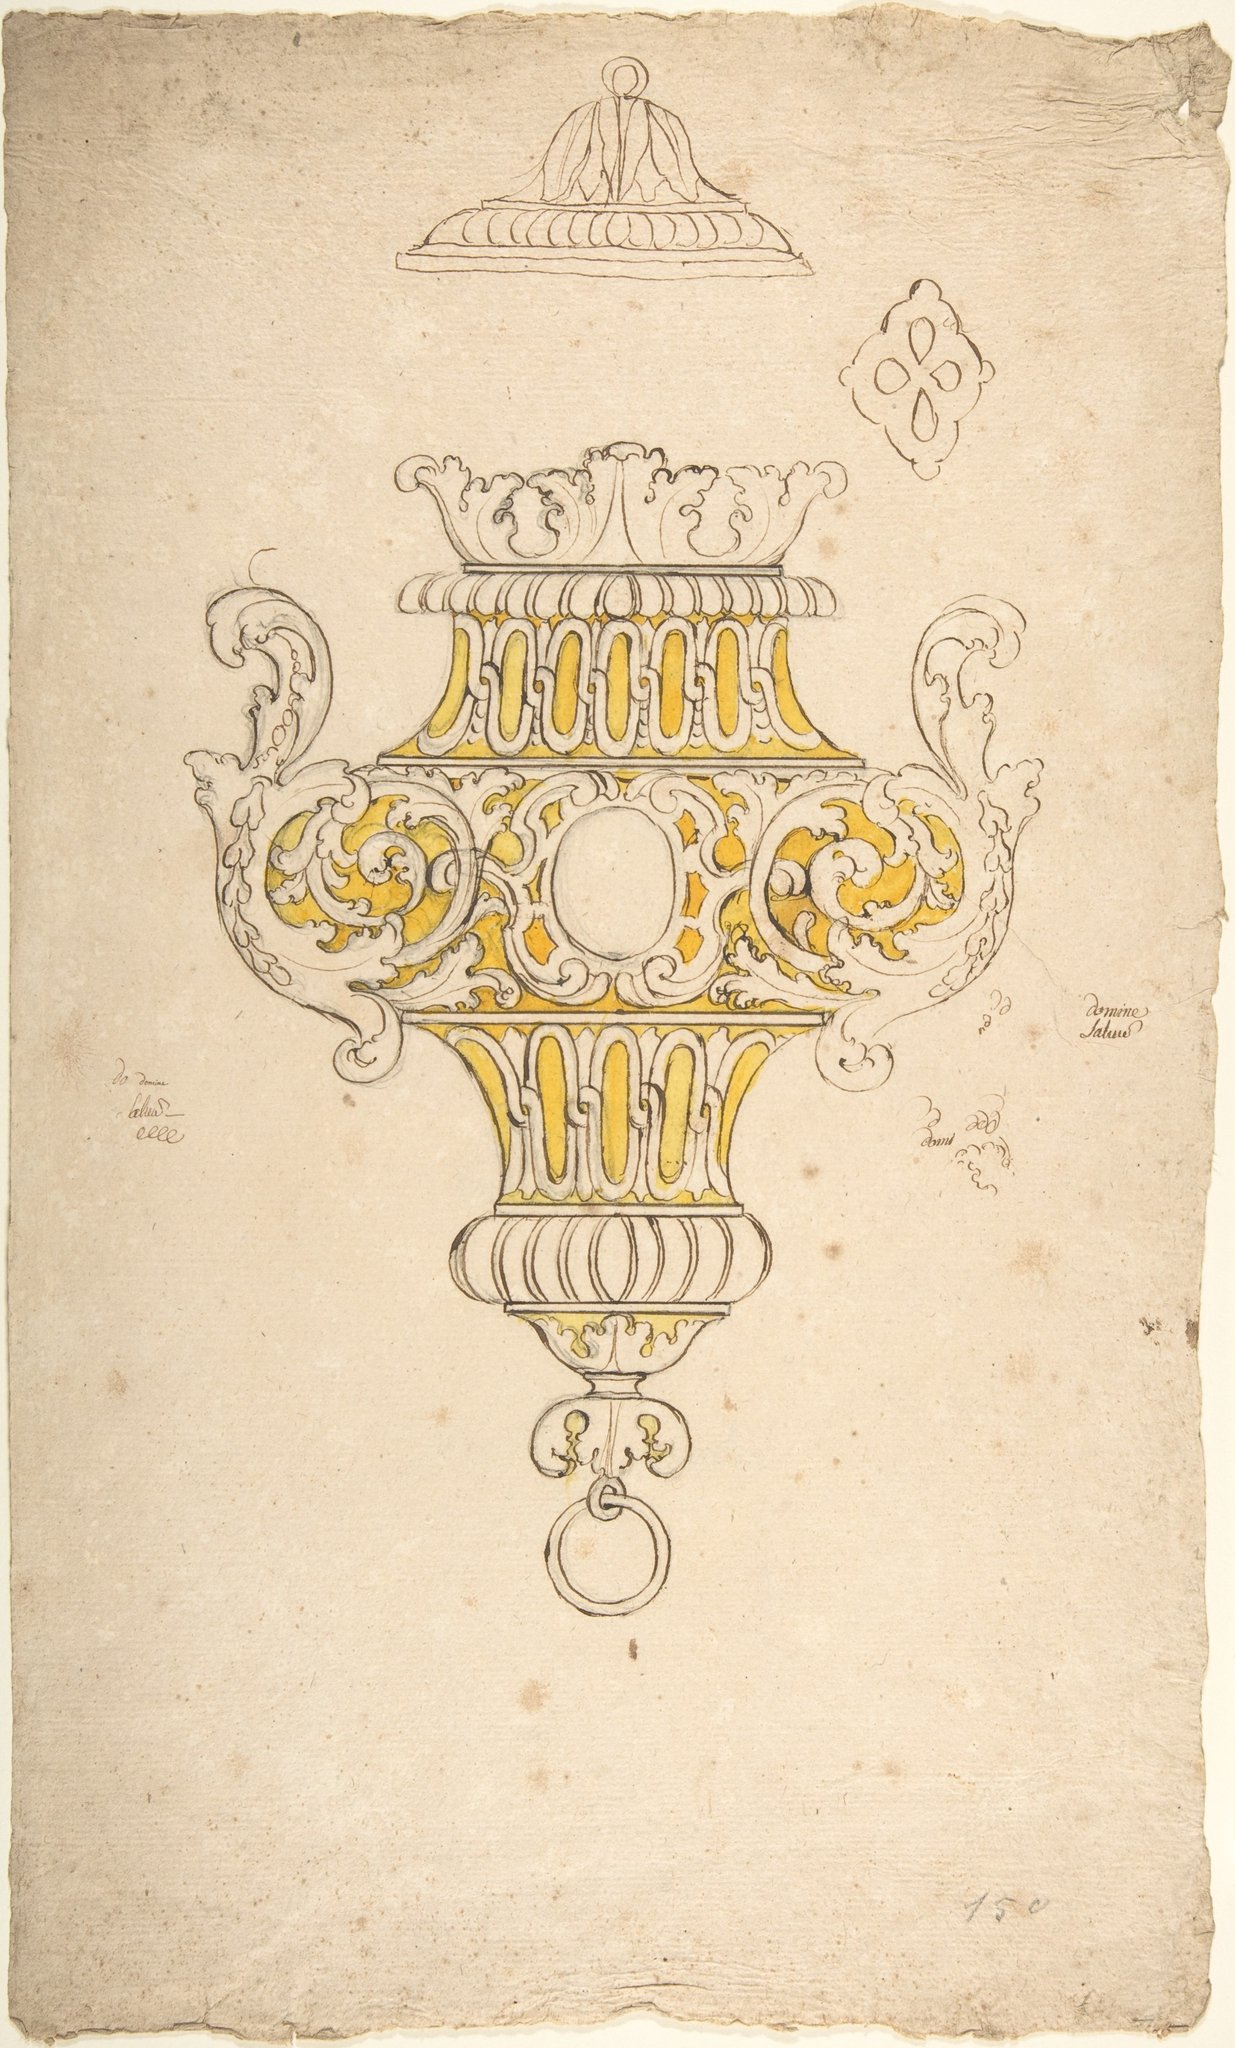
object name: drawing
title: Design for Hanging Vase or Lamp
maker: anonymous, italian, 18th century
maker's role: artist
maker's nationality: italian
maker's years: 1700-1800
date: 1701-1800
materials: ink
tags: lamps,vases